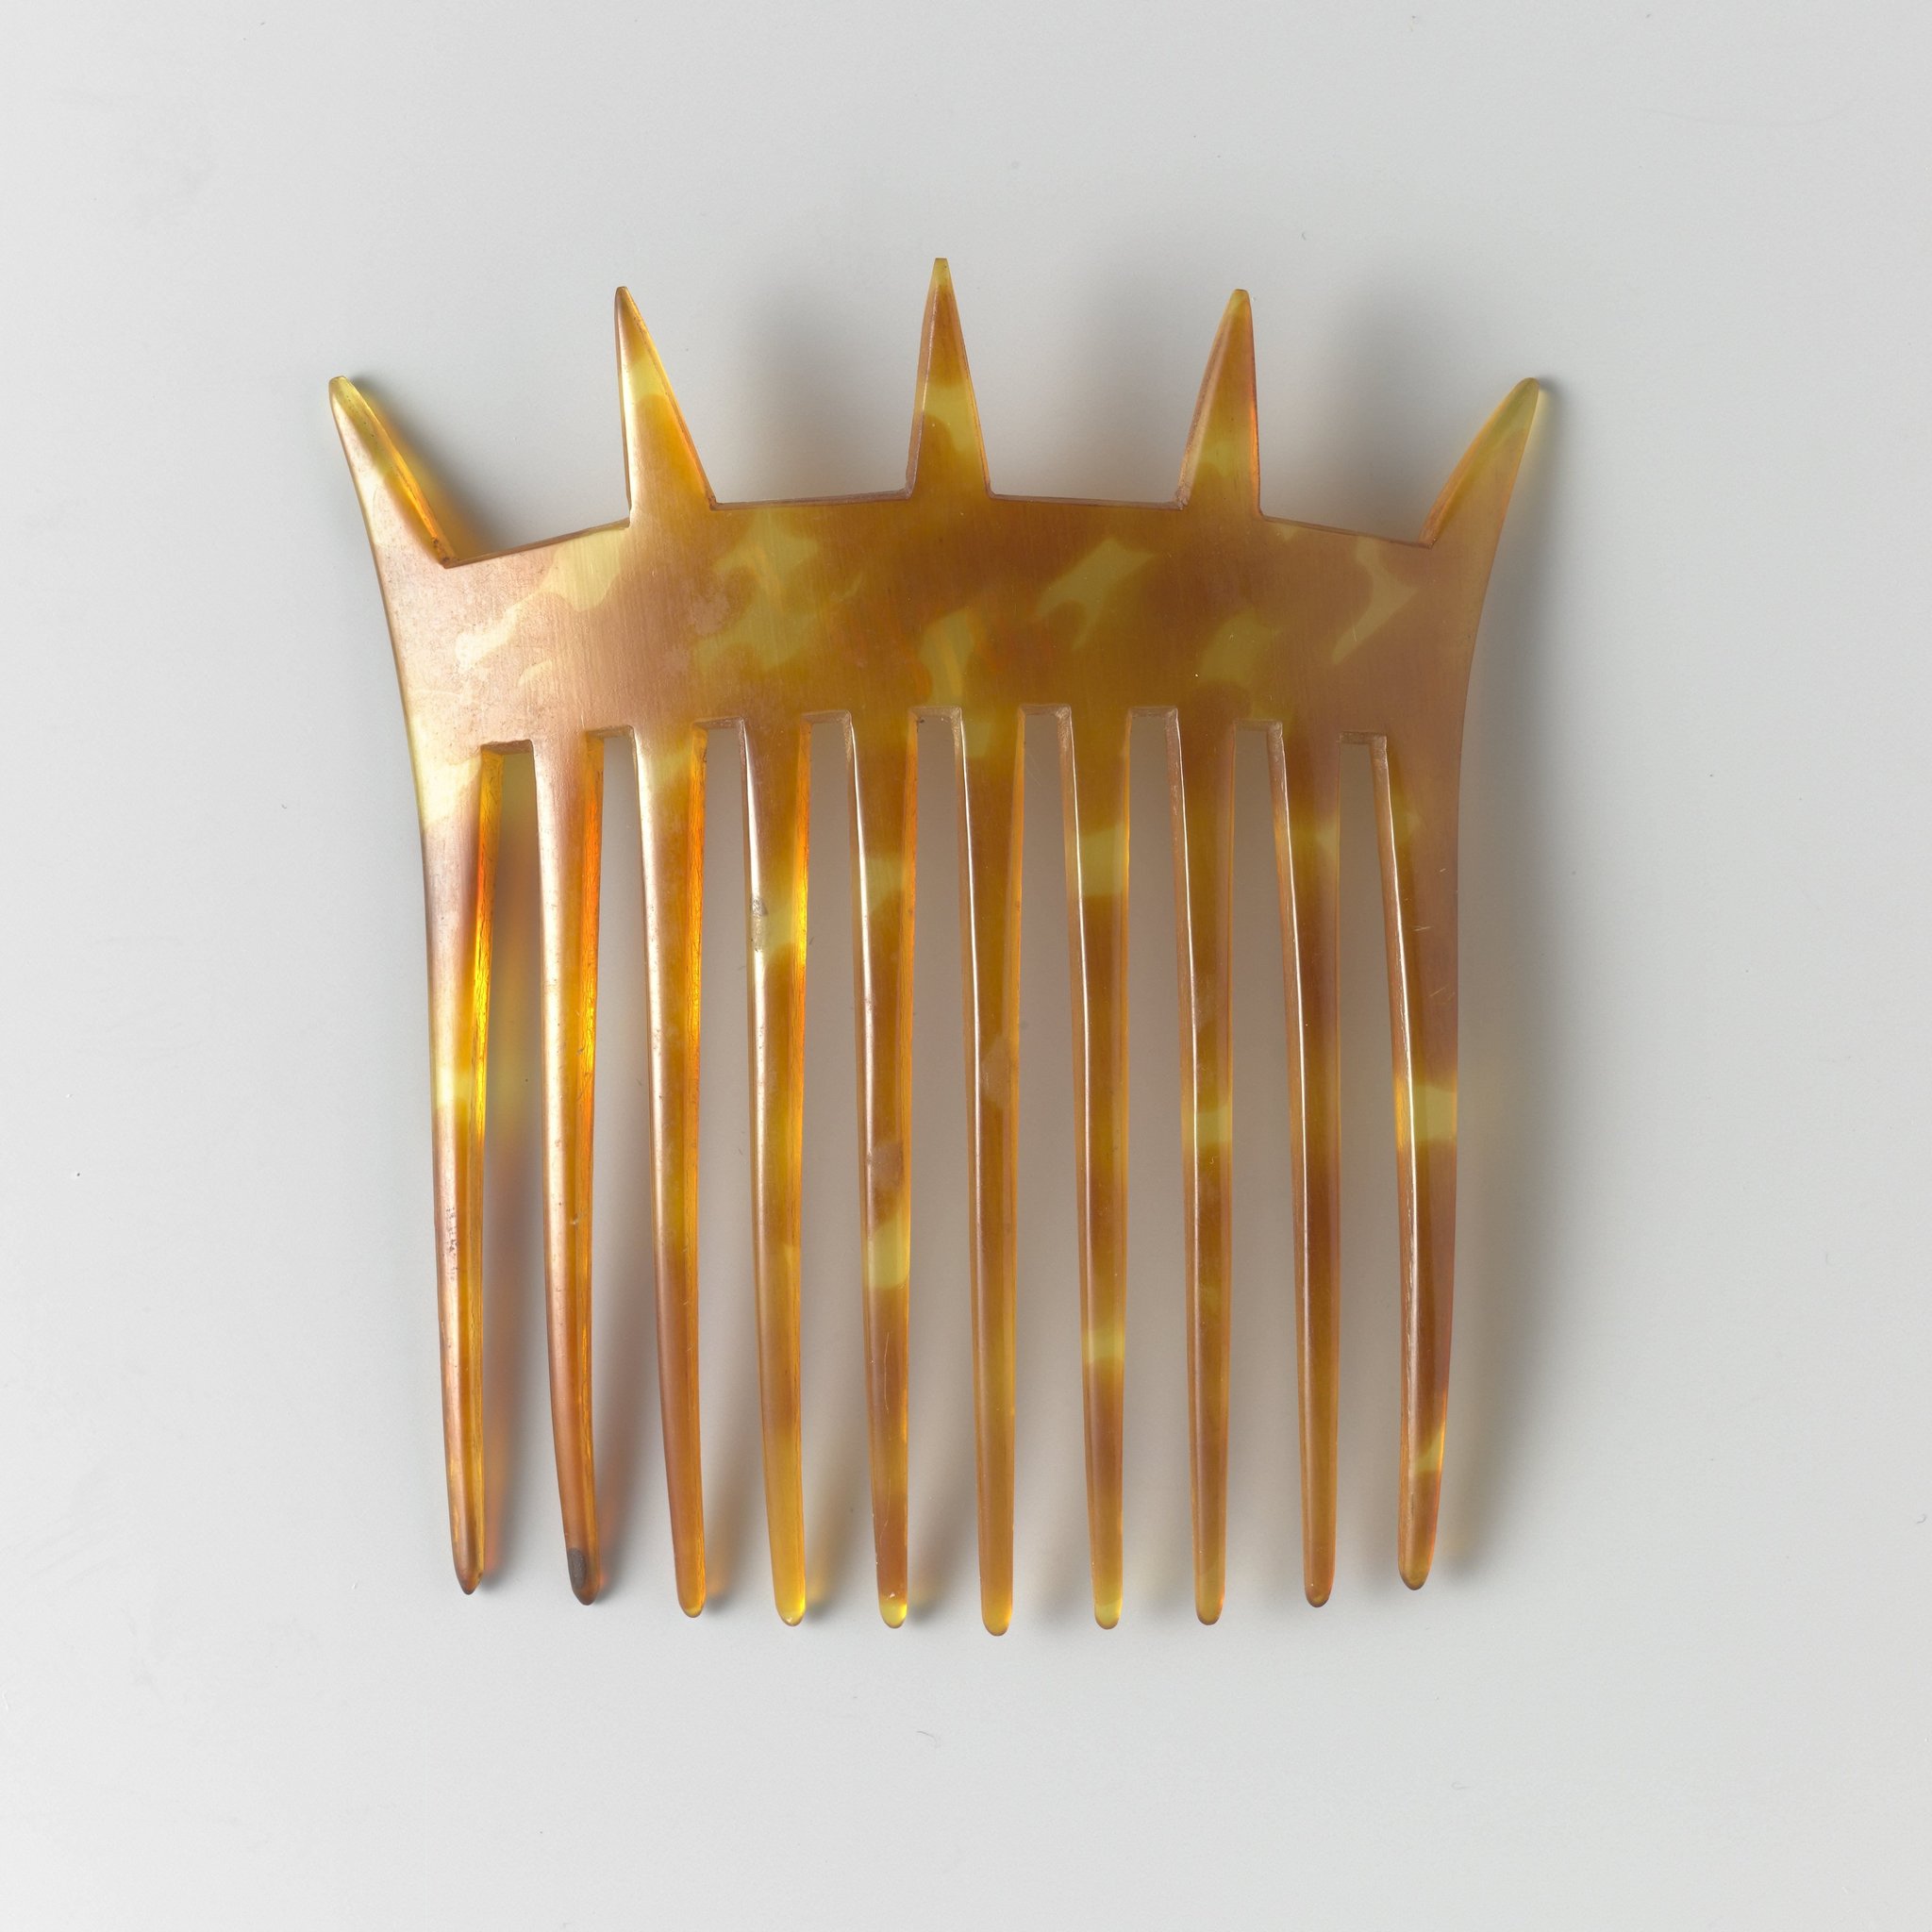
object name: comb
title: Haarkam van blonde imitatie schildpad of hoorn met smalle, gladde rug waarop vijf punten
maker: Anonymous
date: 1800-1810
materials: celluloid, plastic, horn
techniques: filing, polish, pressing, sawing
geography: netherlands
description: Haarkam van blond schildpad, met een smalle rug en vijf punten. In de jaren 1830 werd het haar, met een kruisvormige scheiding over het hoofd, aan de zijkanten en achter opgenomen. Hierbij stak men nog steeds ter ondersteuning, maar ook ter verfraaiing, kammen in het haar.